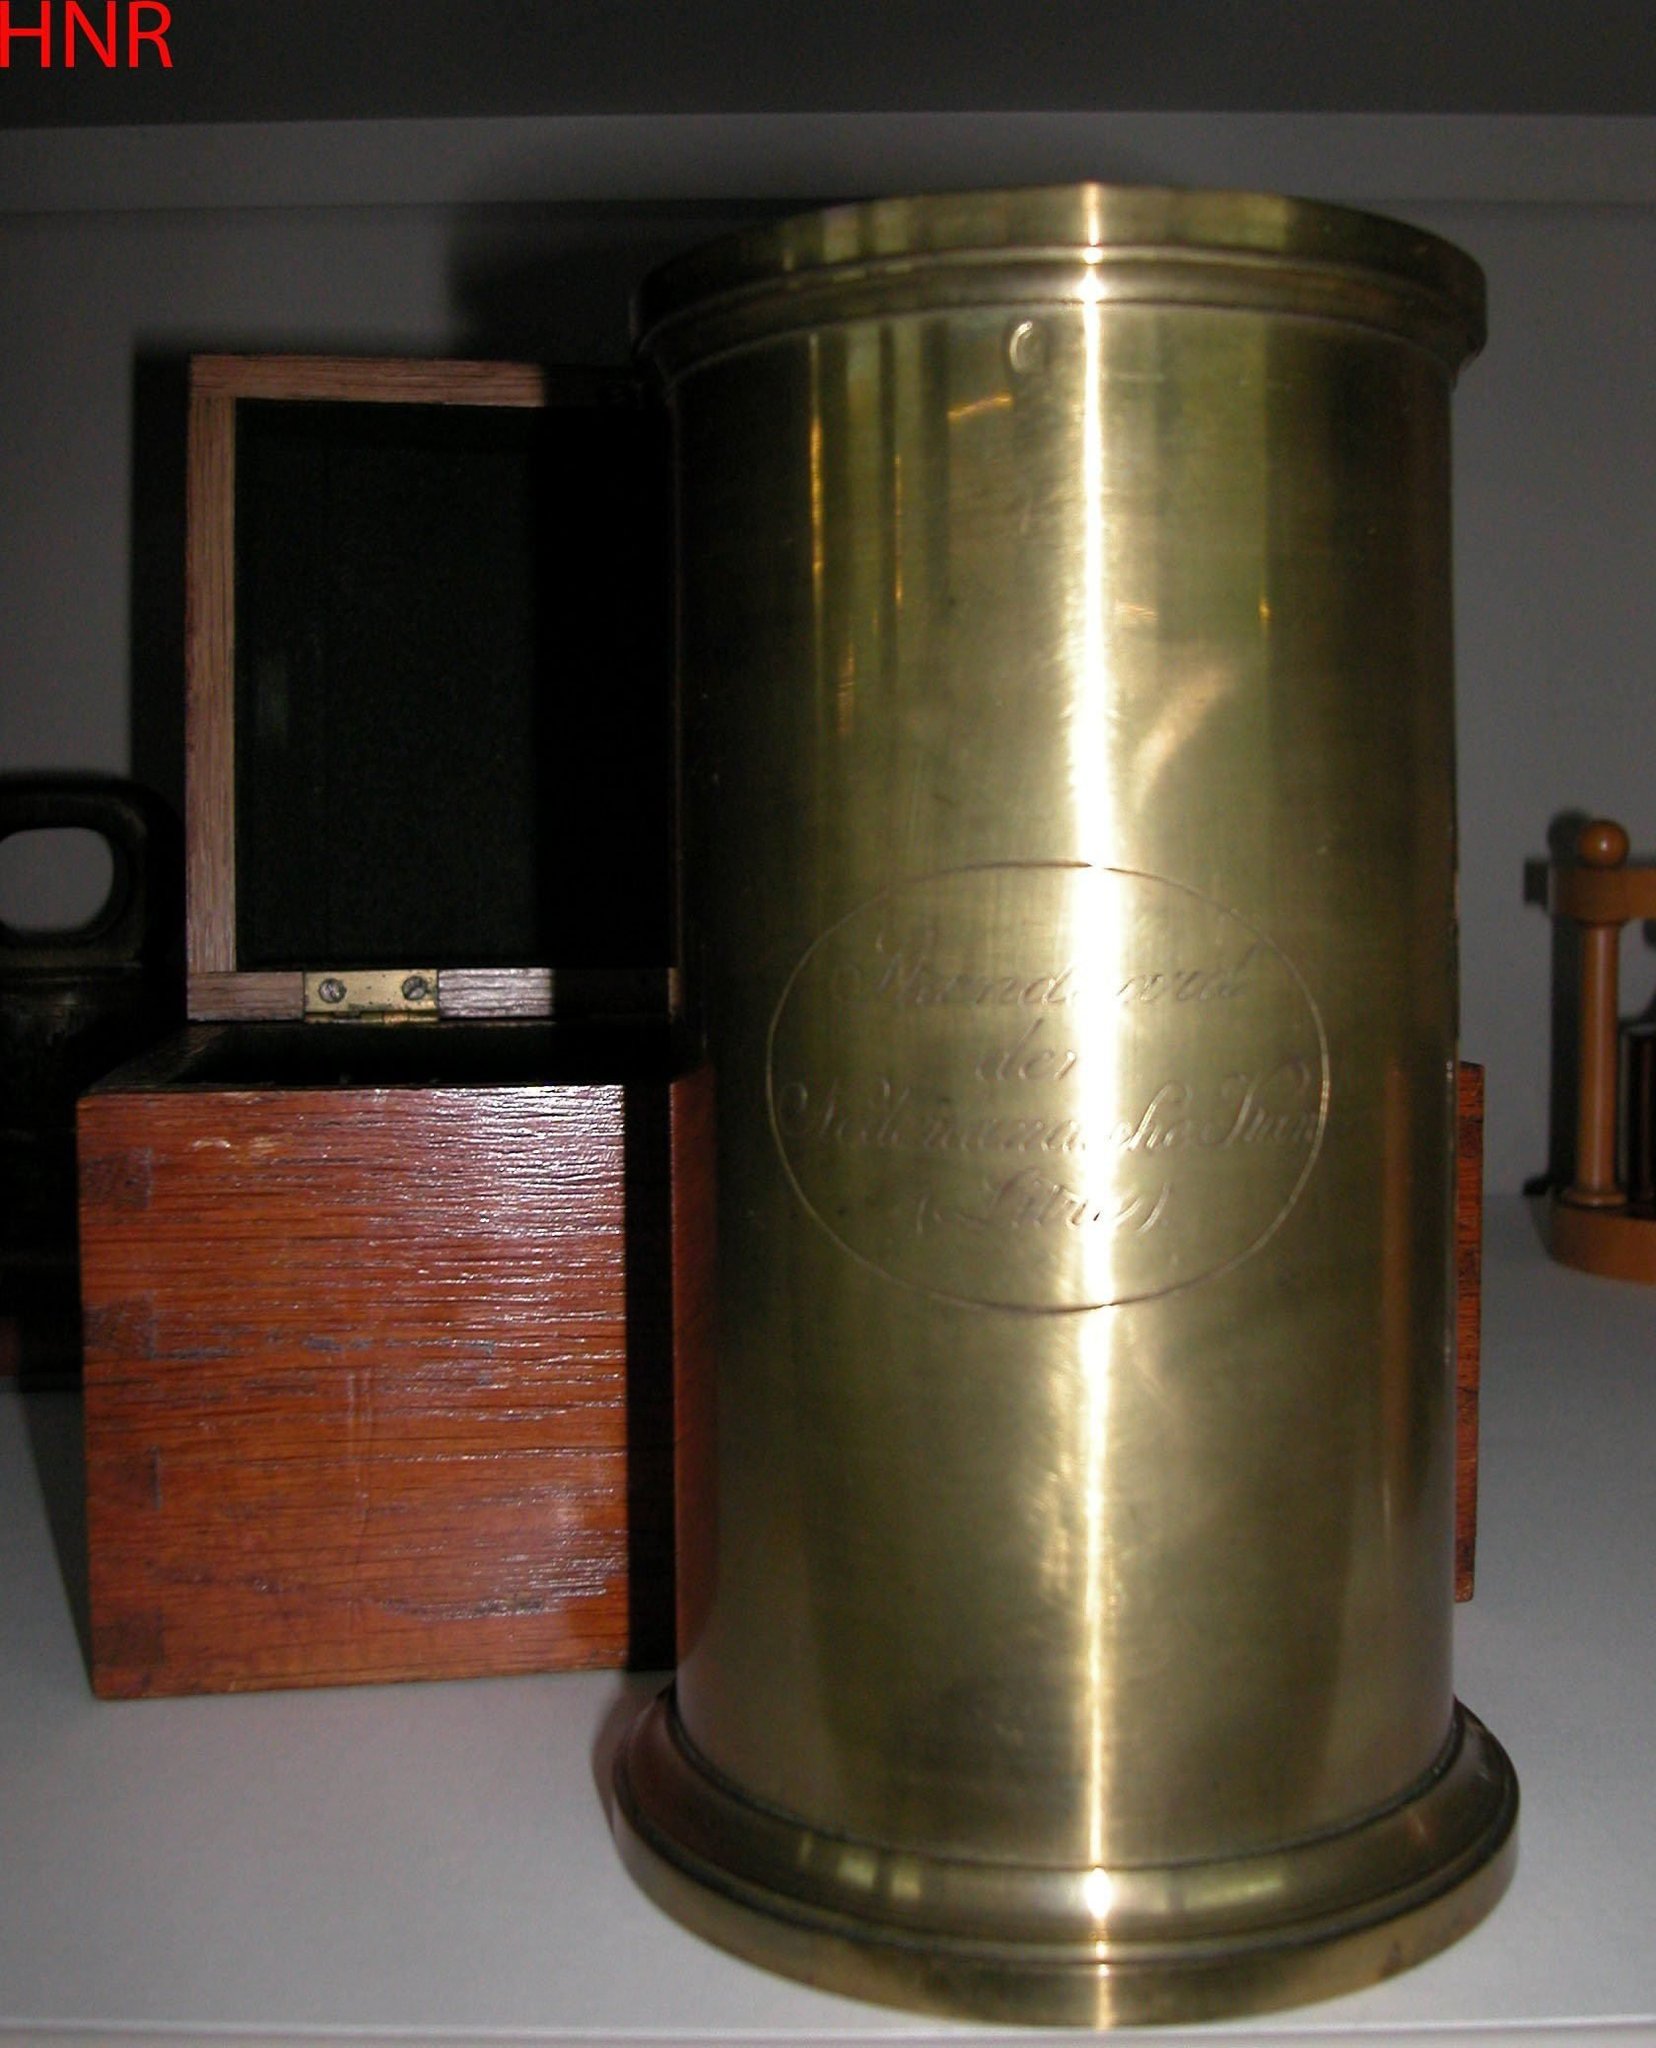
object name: measuring cup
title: Standaard der Nederlandse Kan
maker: Anonymous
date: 1810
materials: brass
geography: netherlands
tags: netherlands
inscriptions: : ‘Standaard der Nederl. Kan. (Litre)’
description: Maatbeker, ca. 1810. Zoals het opschrift aangeeft - ‘Standaard der Nederl. Kan (litre)’ - was de Nederlandsche Kan gelijk aan de liter. Het was een inhoudsmaat voor droge waren. Bruikleen NMi Museum IJkwezen, Delft.